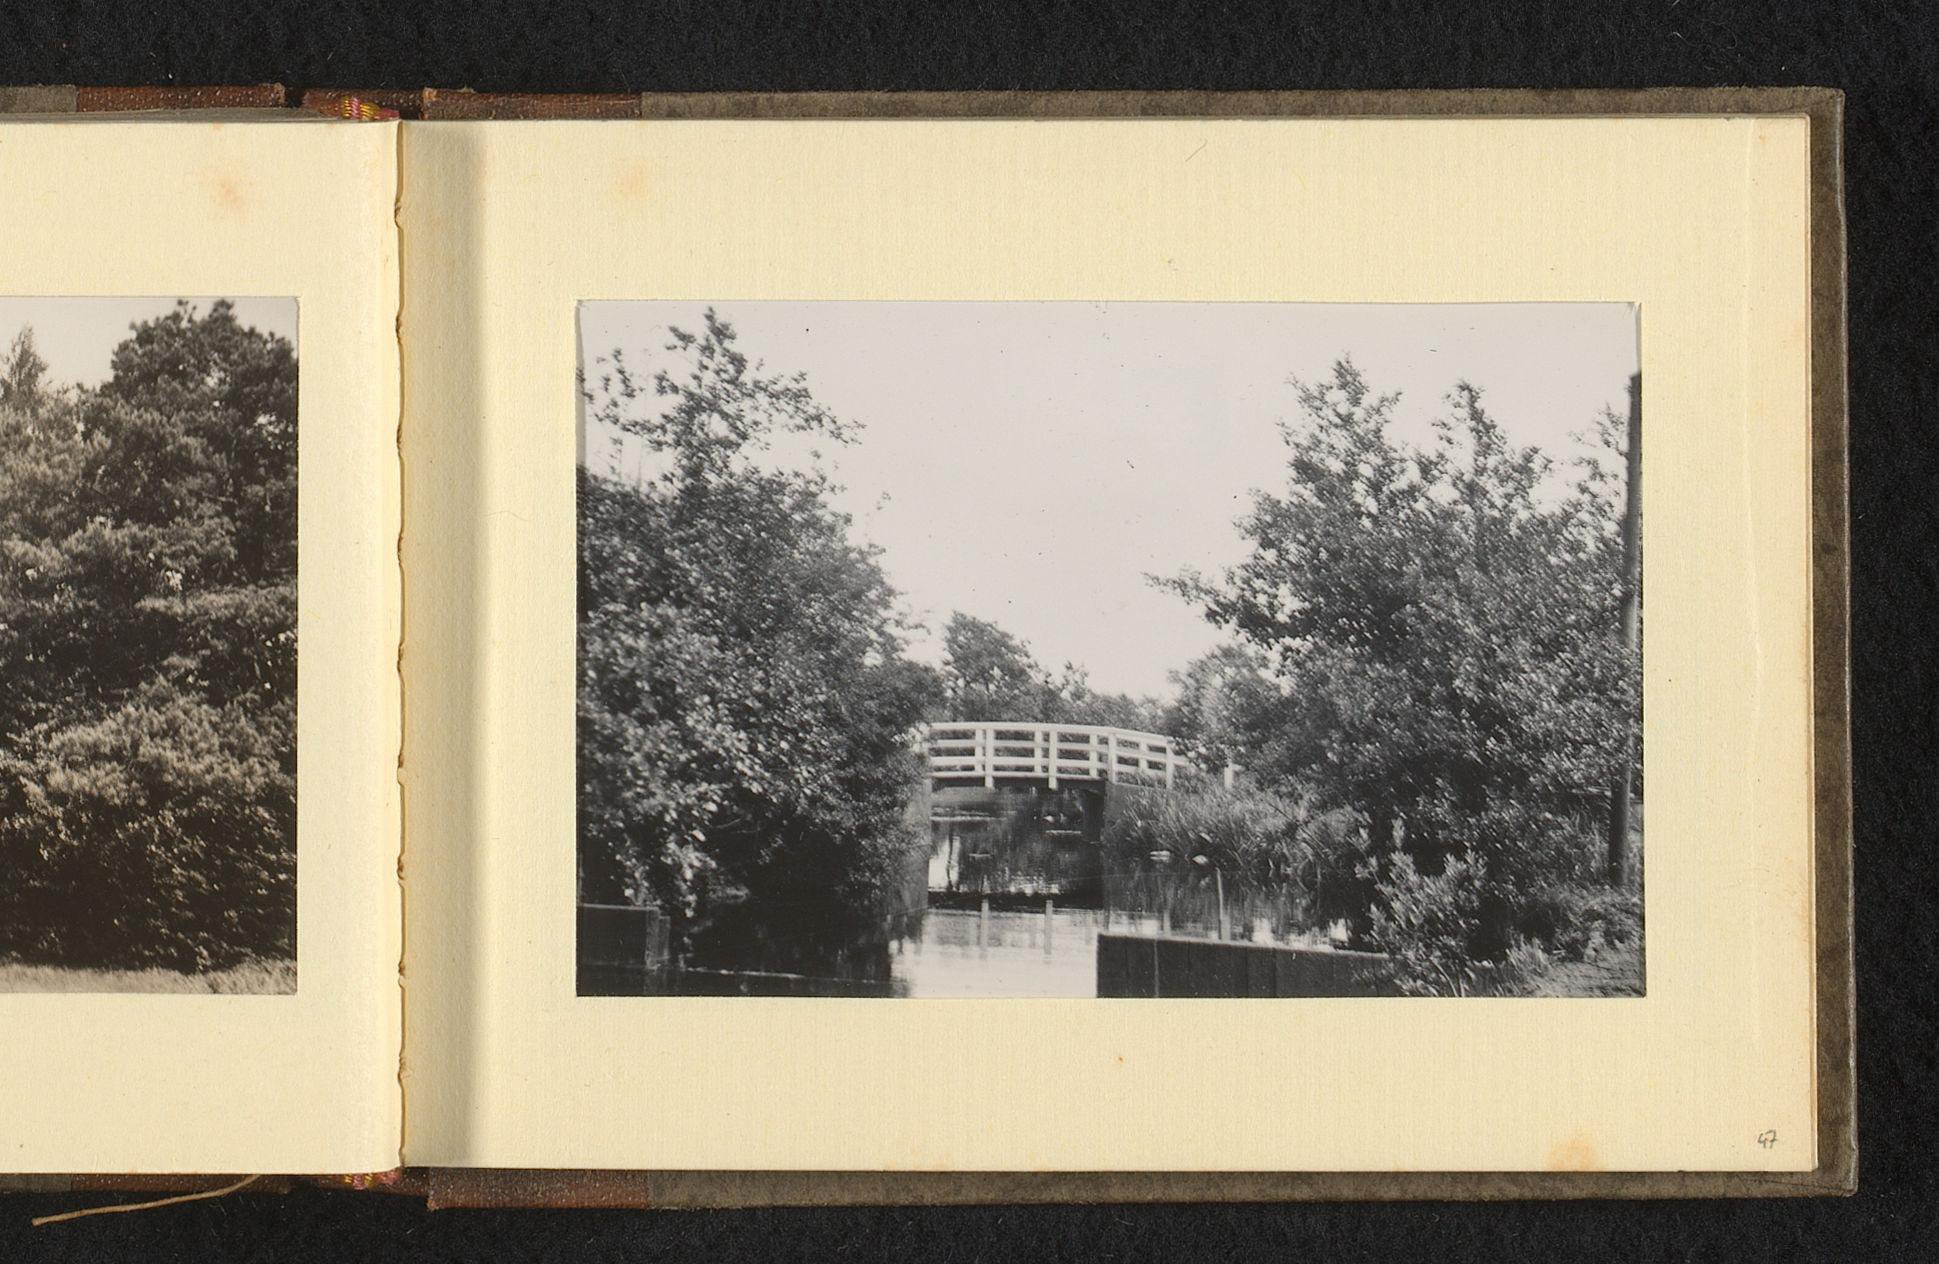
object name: album leaf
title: Brug over een rivier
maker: norbert van den berg (1901-1972)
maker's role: amateurfotograaf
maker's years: 1901-1972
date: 1935-1950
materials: paper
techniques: gelatin silver print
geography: netherlands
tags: river, bridge